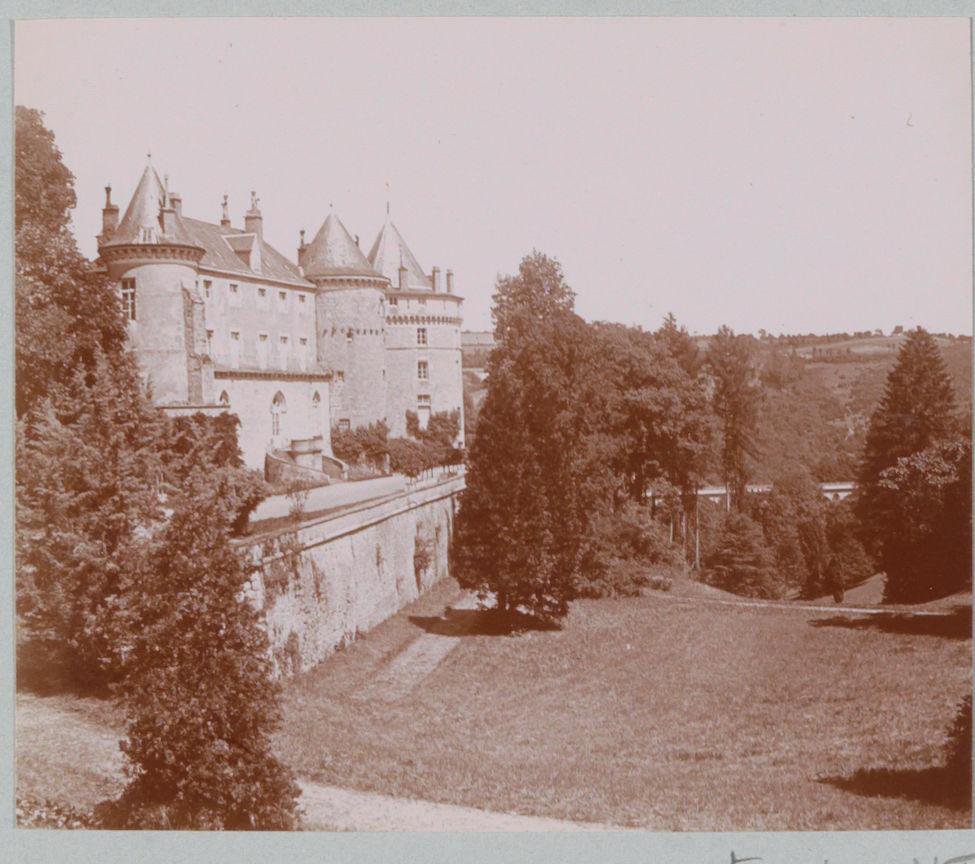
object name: photograph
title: Gezicht op een kasteel met een terras en een tuin, vermoedelijk in Frankrijk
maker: Anonymous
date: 1905-1910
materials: paper, photographic support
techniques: gelatin silver print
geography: france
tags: castle, garden, terrace, france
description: Onderdeel van Fotoalbum van een Franse amateurfotograaf met bezienswaardigheden in Frankrijk, Zwitserland en Italië.